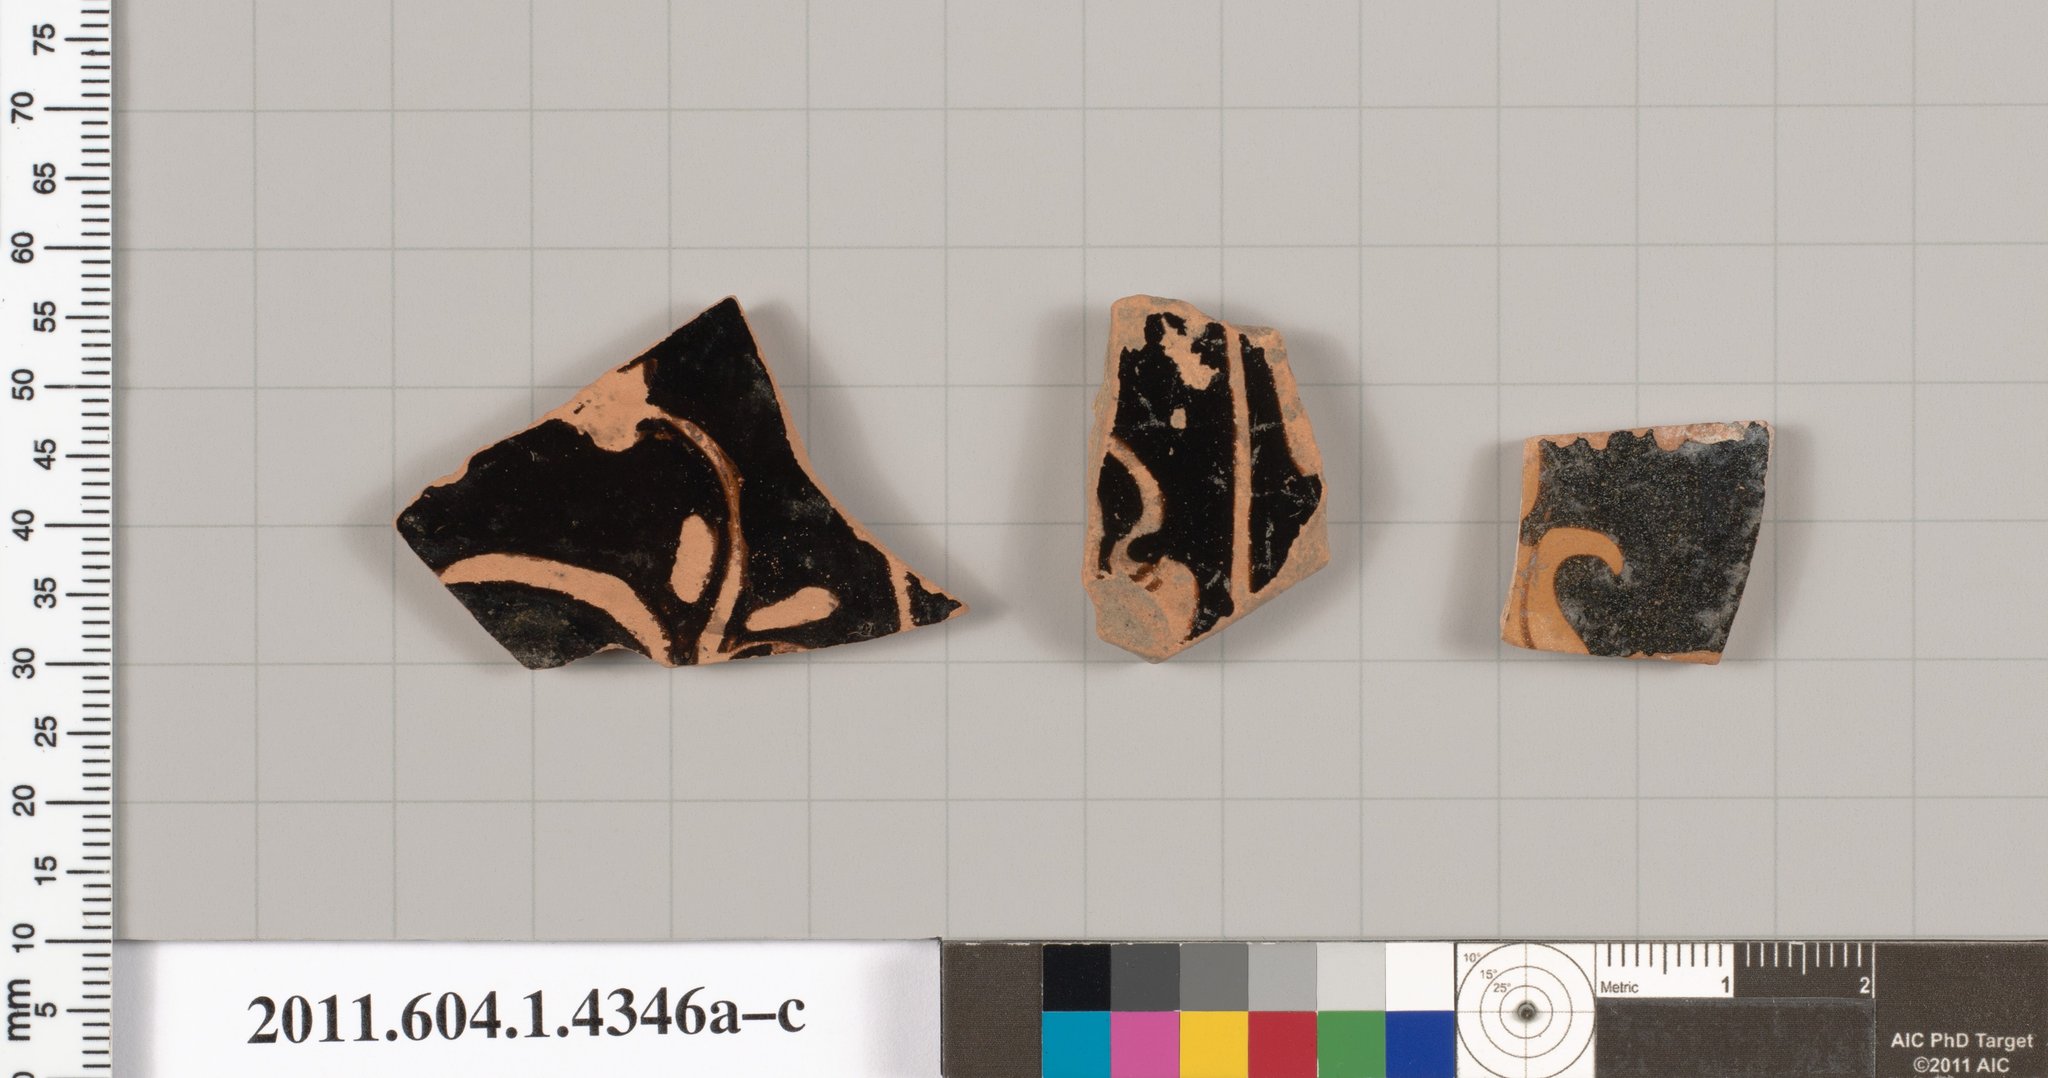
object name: kylix fragment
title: Terracotta fragments of kylikes (drinking cups)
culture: greek, attic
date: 475-451 BCE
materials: terracotta